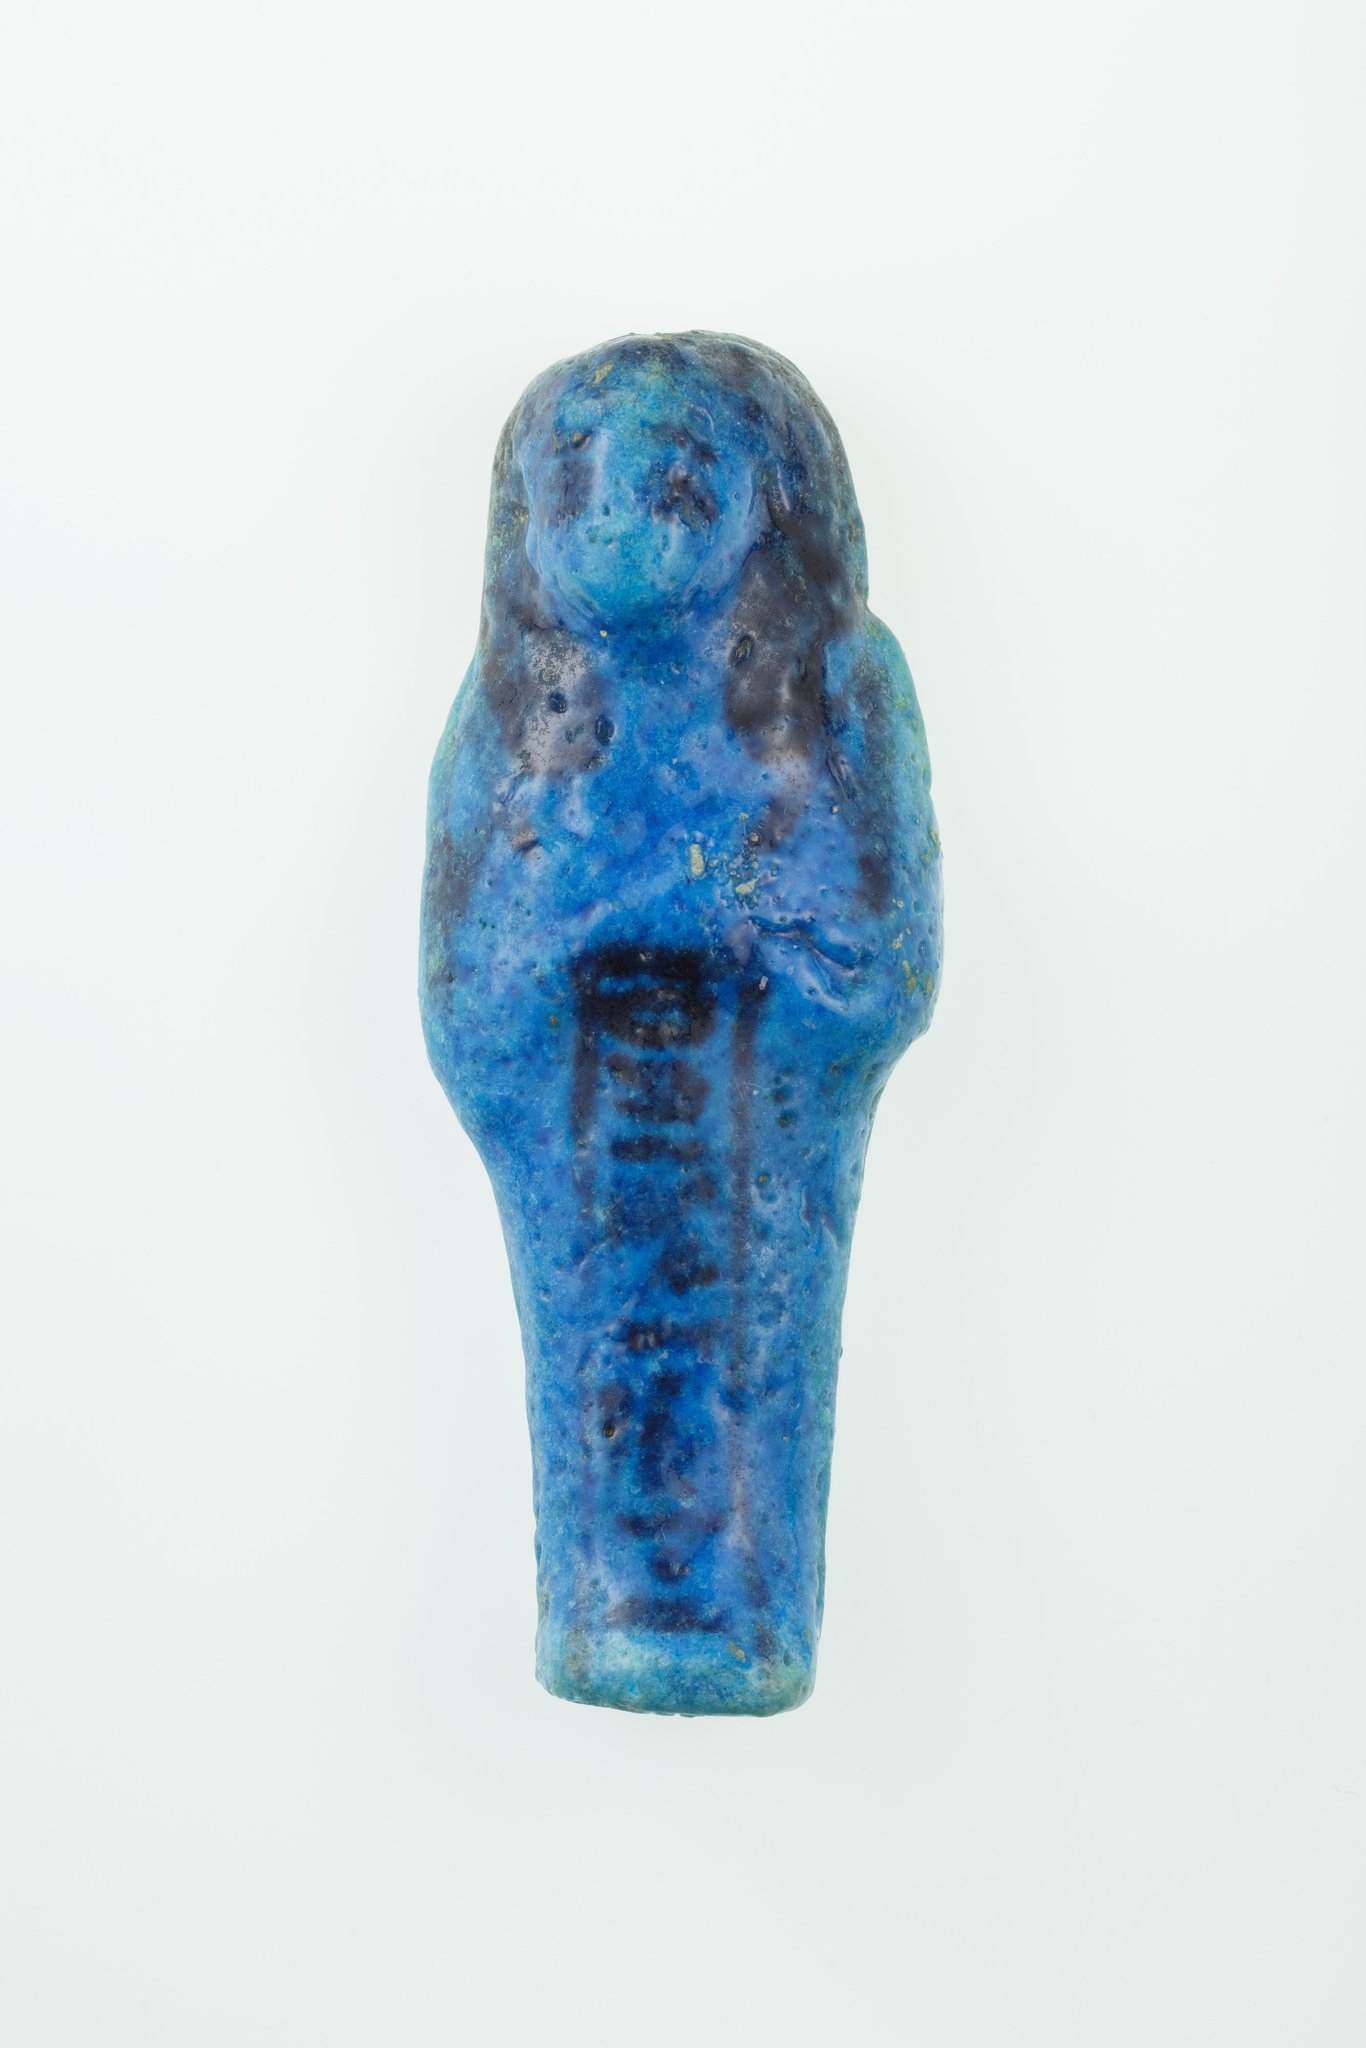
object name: shabti, worker, nauny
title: Worker Shabti of Nauny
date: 1050 BCE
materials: faience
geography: egypt